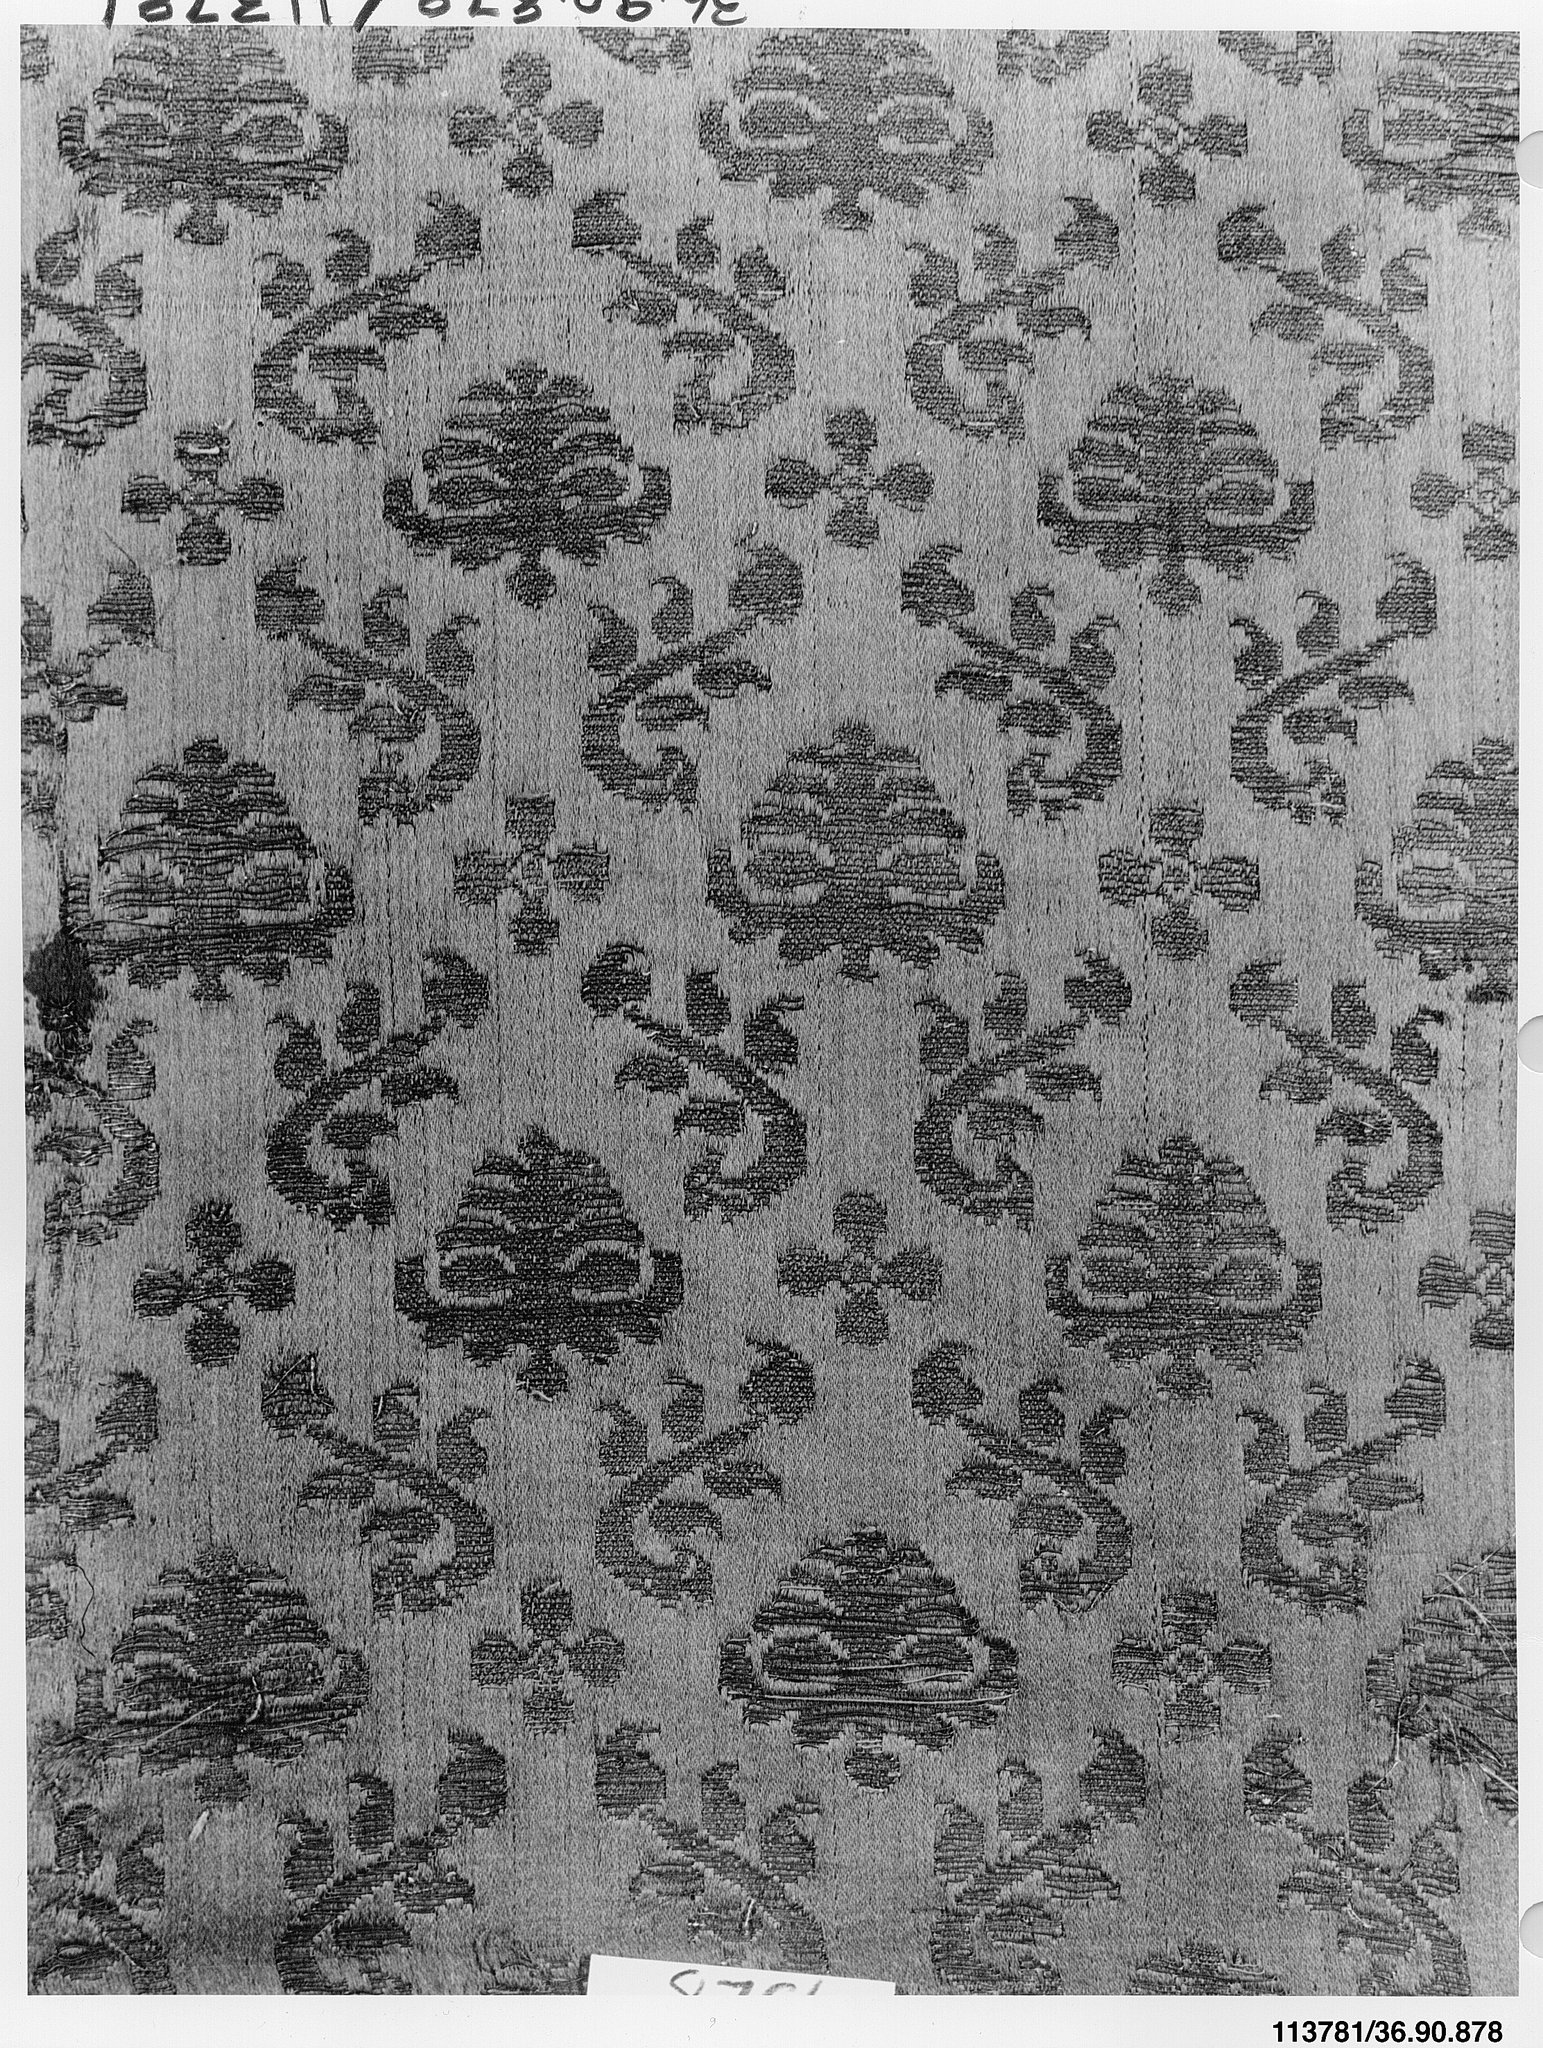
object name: piece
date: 1601-1700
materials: metal thread, silk